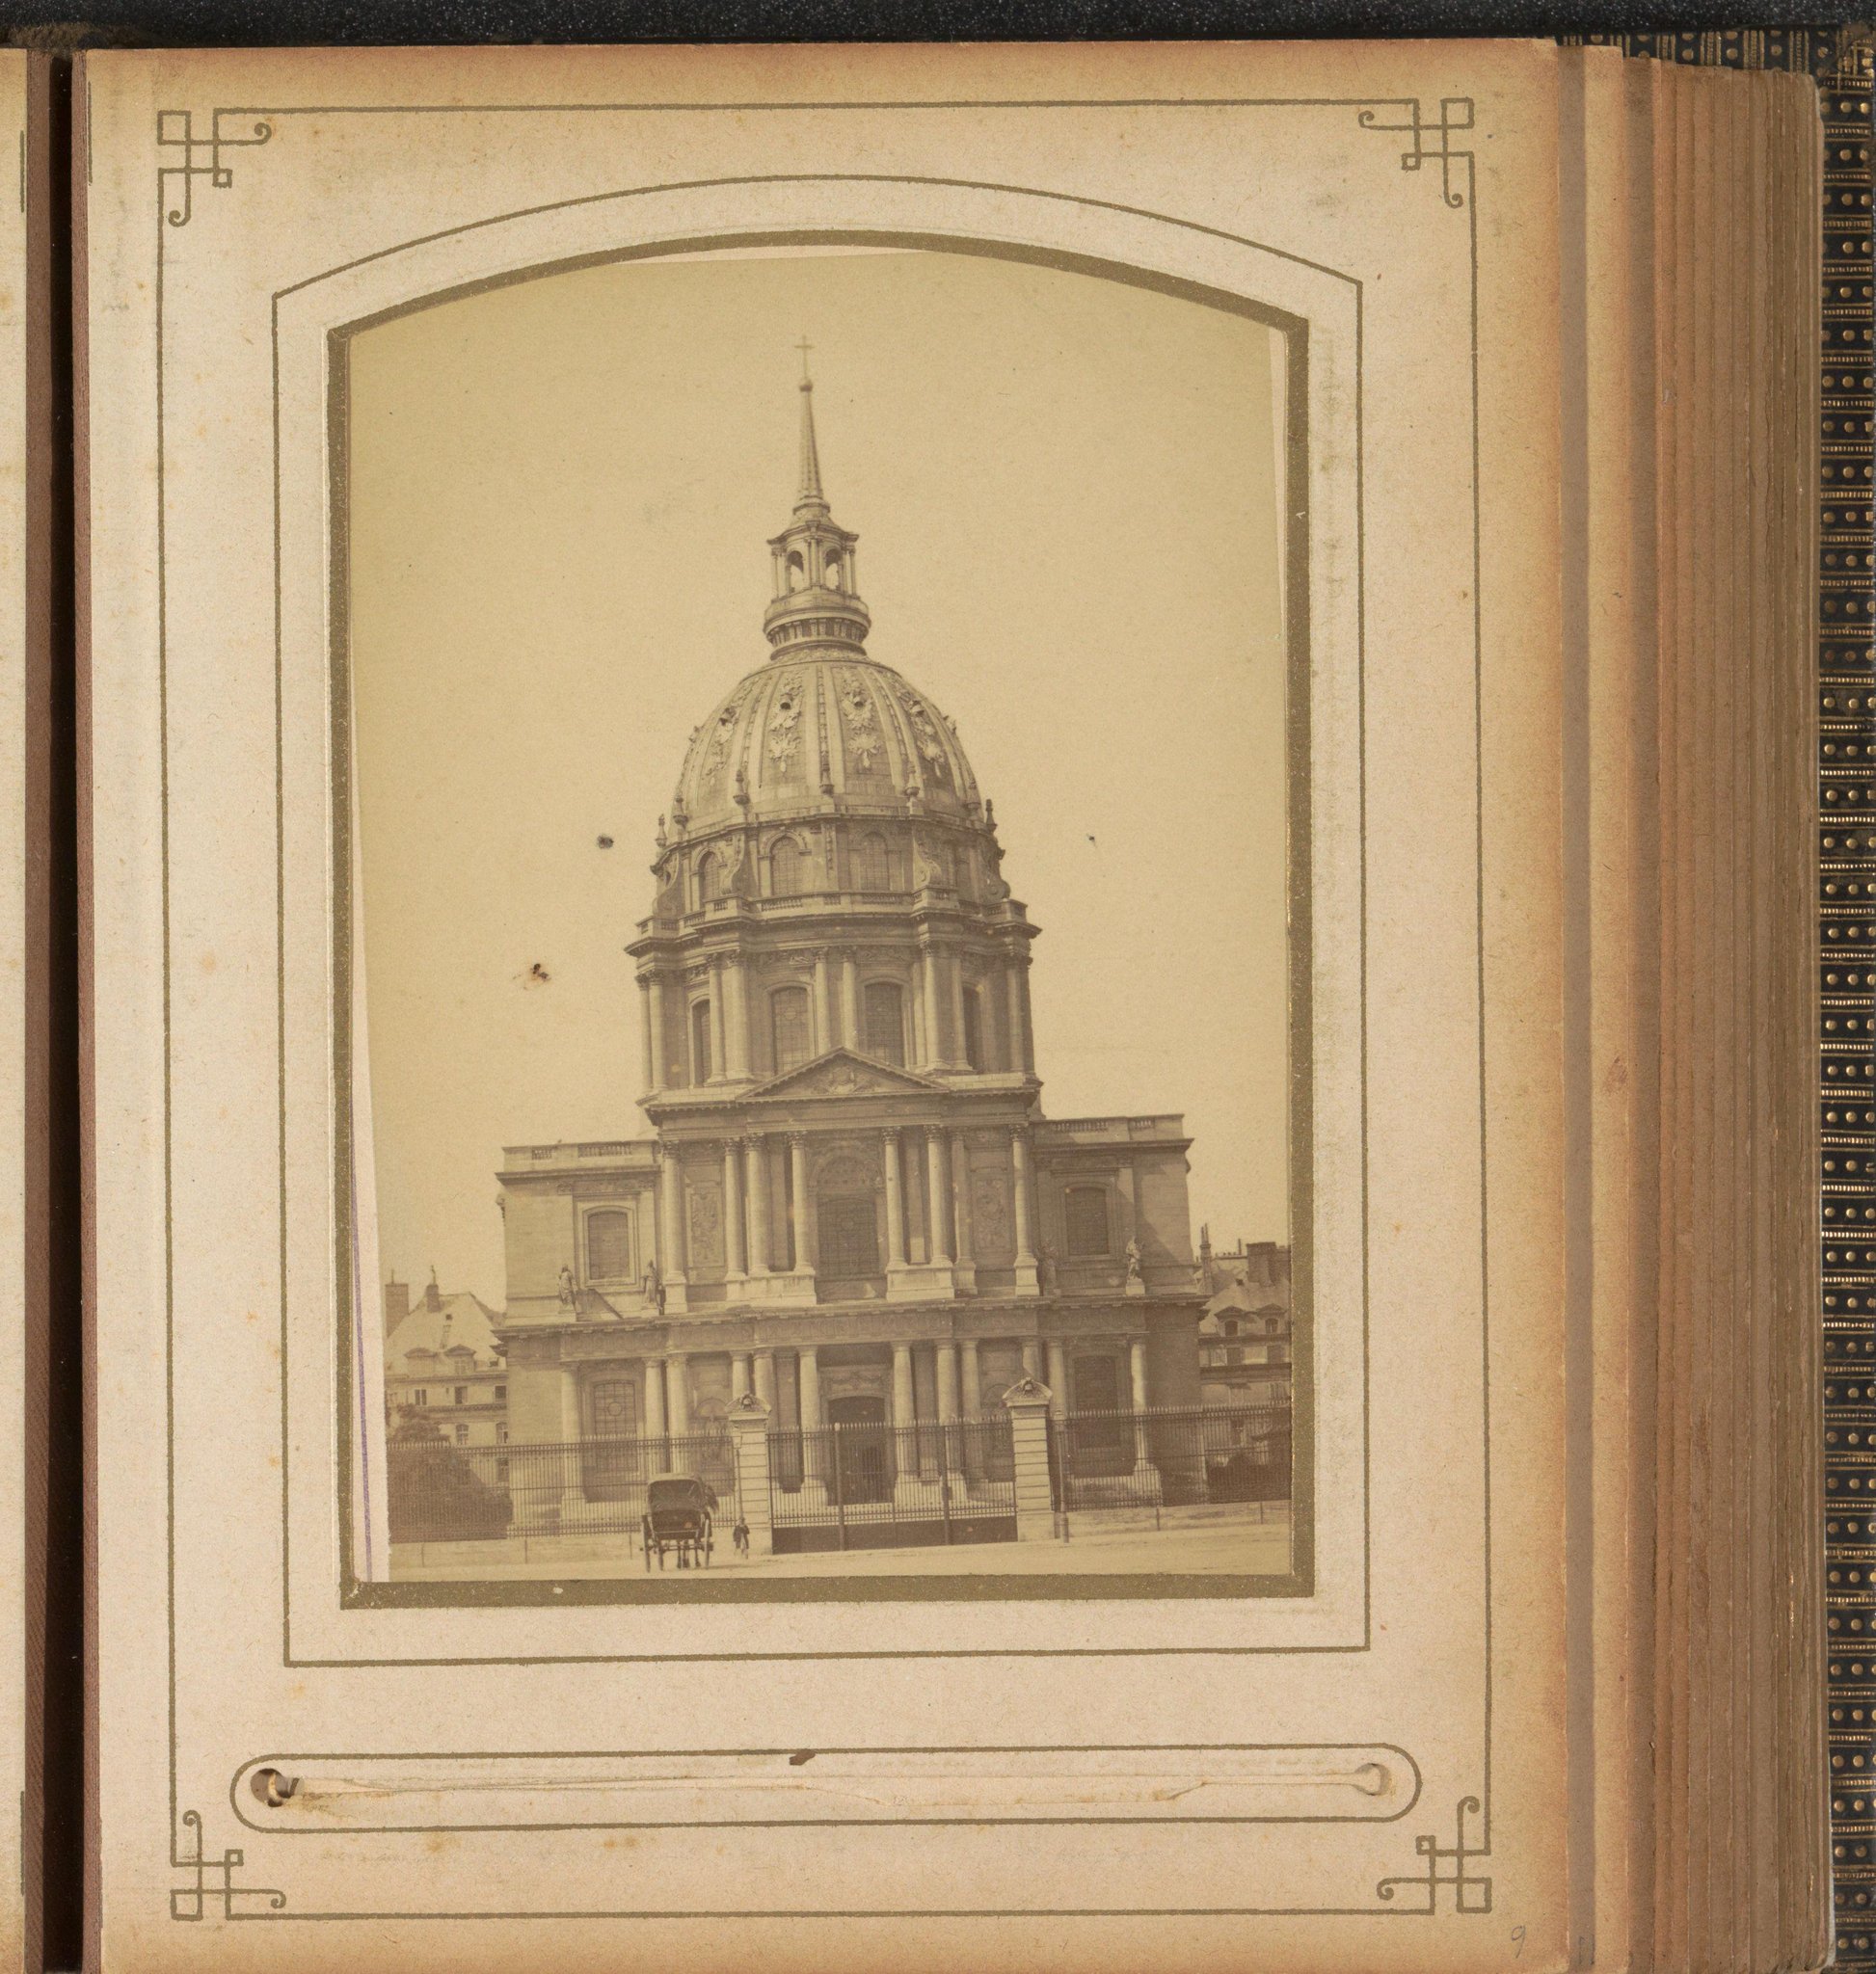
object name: photograph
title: Exterieur van de Saint-Louis-des-Invalides met de Dôme des Invalides in Parijs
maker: Anonymous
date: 1870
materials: cardboard, paper, photographic support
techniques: albumen print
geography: paris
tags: church (exterior), dome ~ architecture, paris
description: Onderdeel van Fotoalbum met kabinetfoto's van bezienswaardigheden in Parijs.